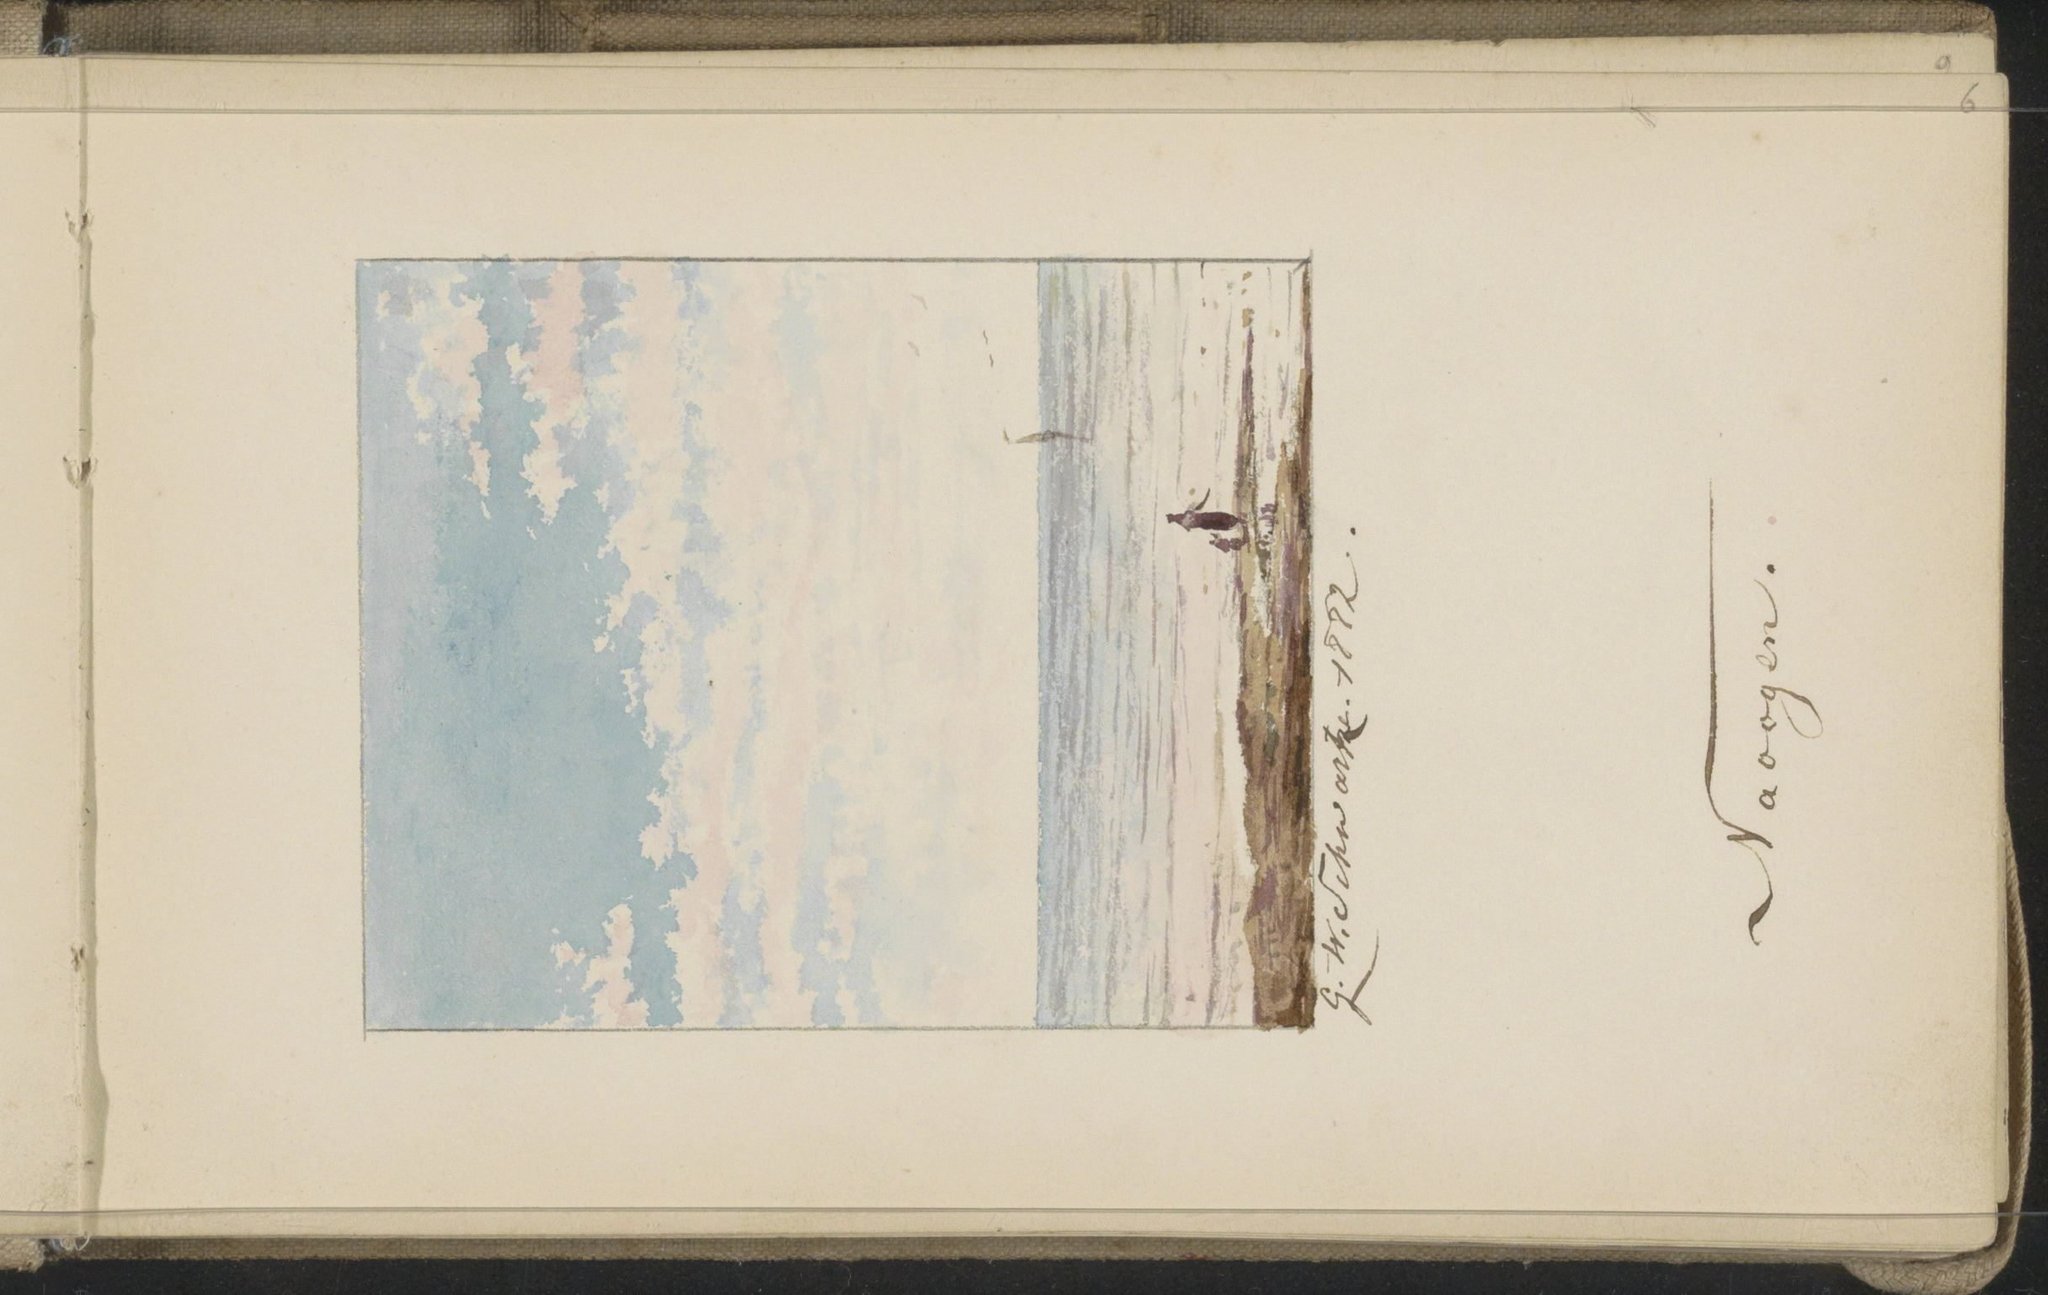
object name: sketchbook leaf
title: Vrouw en kind uitkijkend over zee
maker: george washington schwartze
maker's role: draughtsman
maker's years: 1857-1909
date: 1882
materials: ink, paper, pencil, watercolor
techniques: brush, pen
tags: landscapes with waters, waterscapes, seascapes (in the temperate zone) (+ landscape with figures, staffage)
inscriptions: signature and date: ‘G.W.Schwartze. 1882.’, title: ‘Naoogen.’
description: Tekening in een kader. Blad 6 recto uit een schetsboek met 54 bladen.